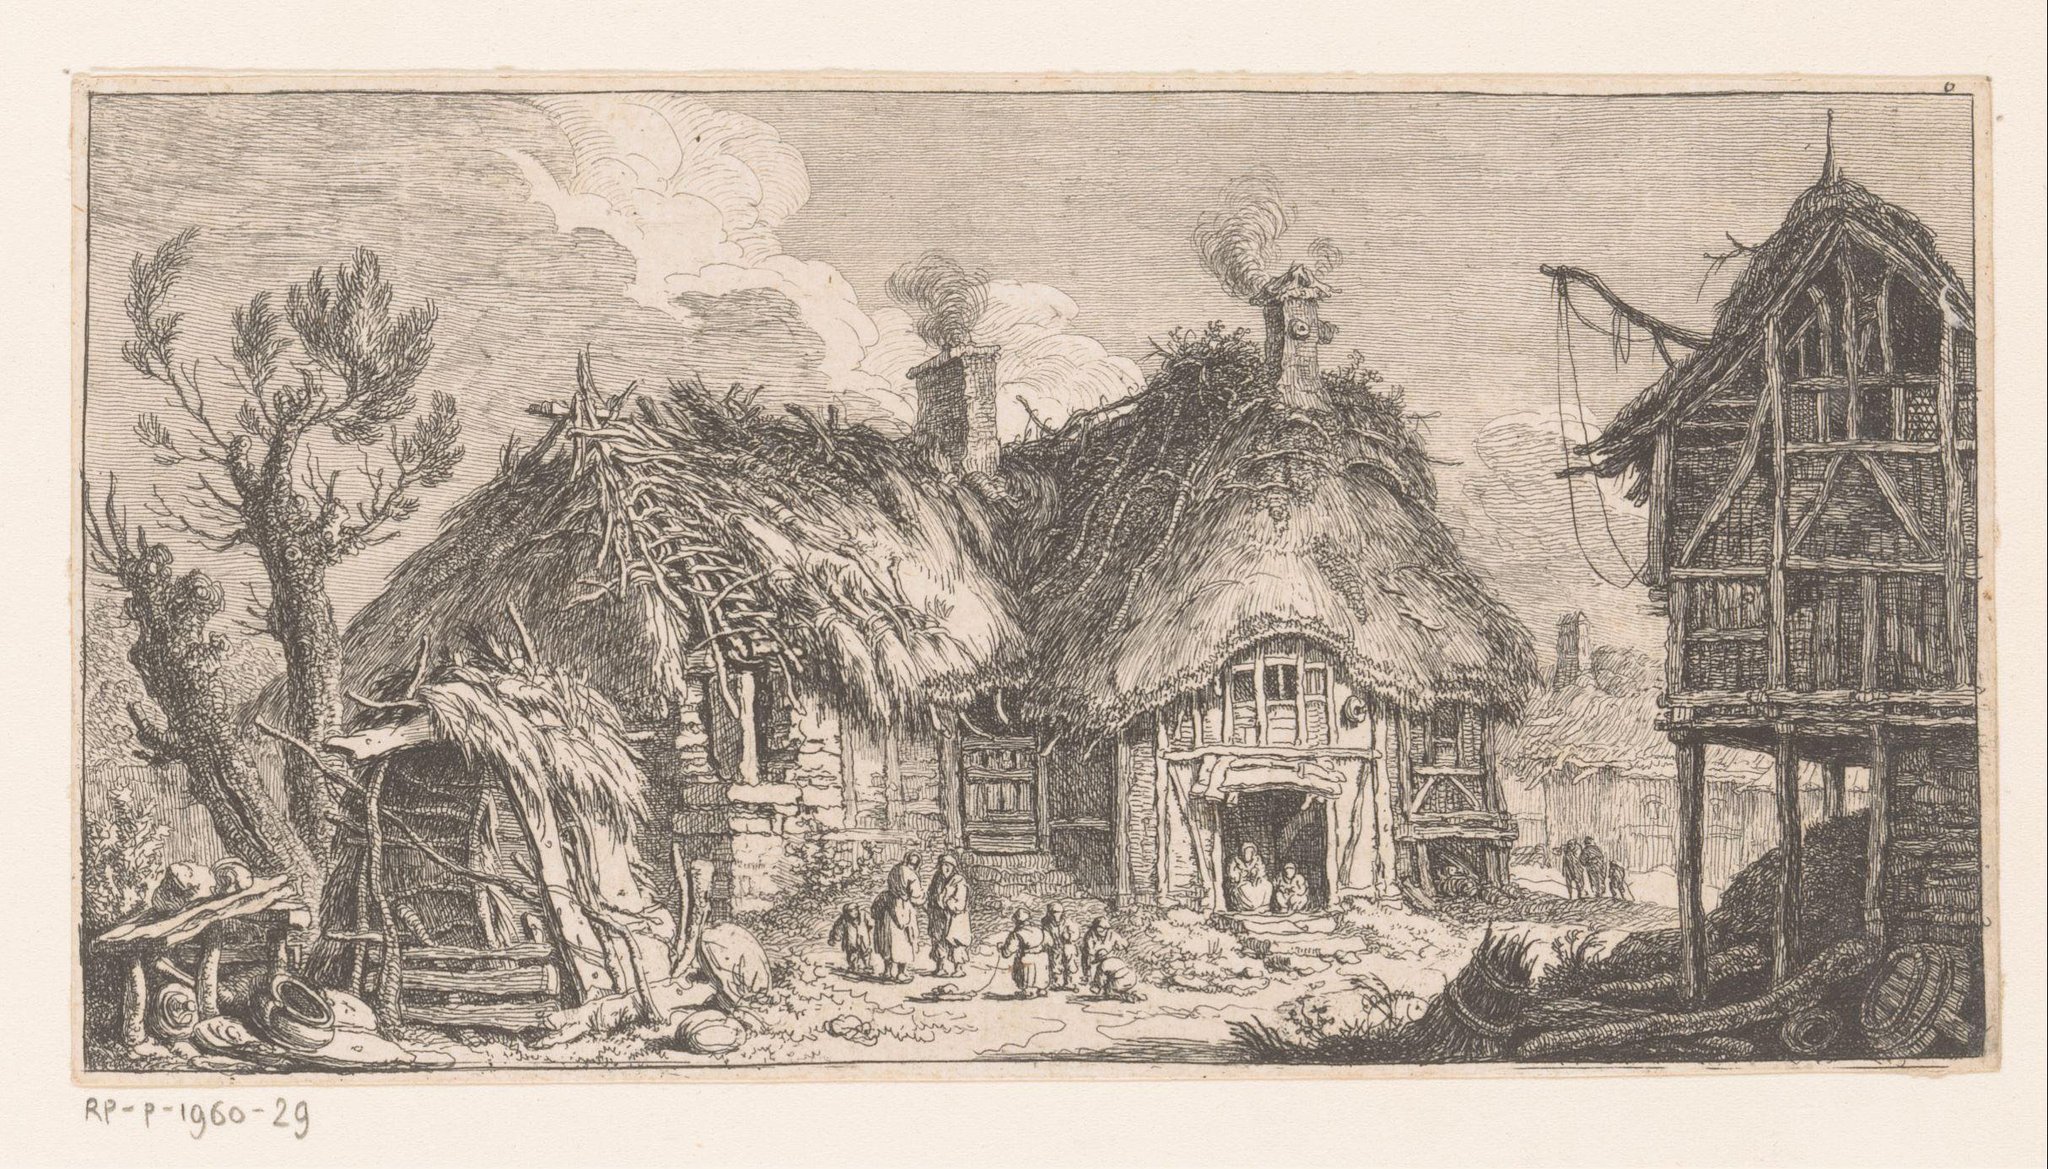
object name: print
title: Vrouwen en kinderen bij een boerderij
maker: franz edmund weirotter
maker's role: draughtsman, painter, print maker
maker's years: 1733-1771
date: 1766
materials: paper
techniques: etching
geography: paris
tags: farm or solitary house in landscape, mother and child(ren), woman and child(ren) (family group)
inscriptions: collector's mark: Lugt 2760, collector's mark: Lugt 2228